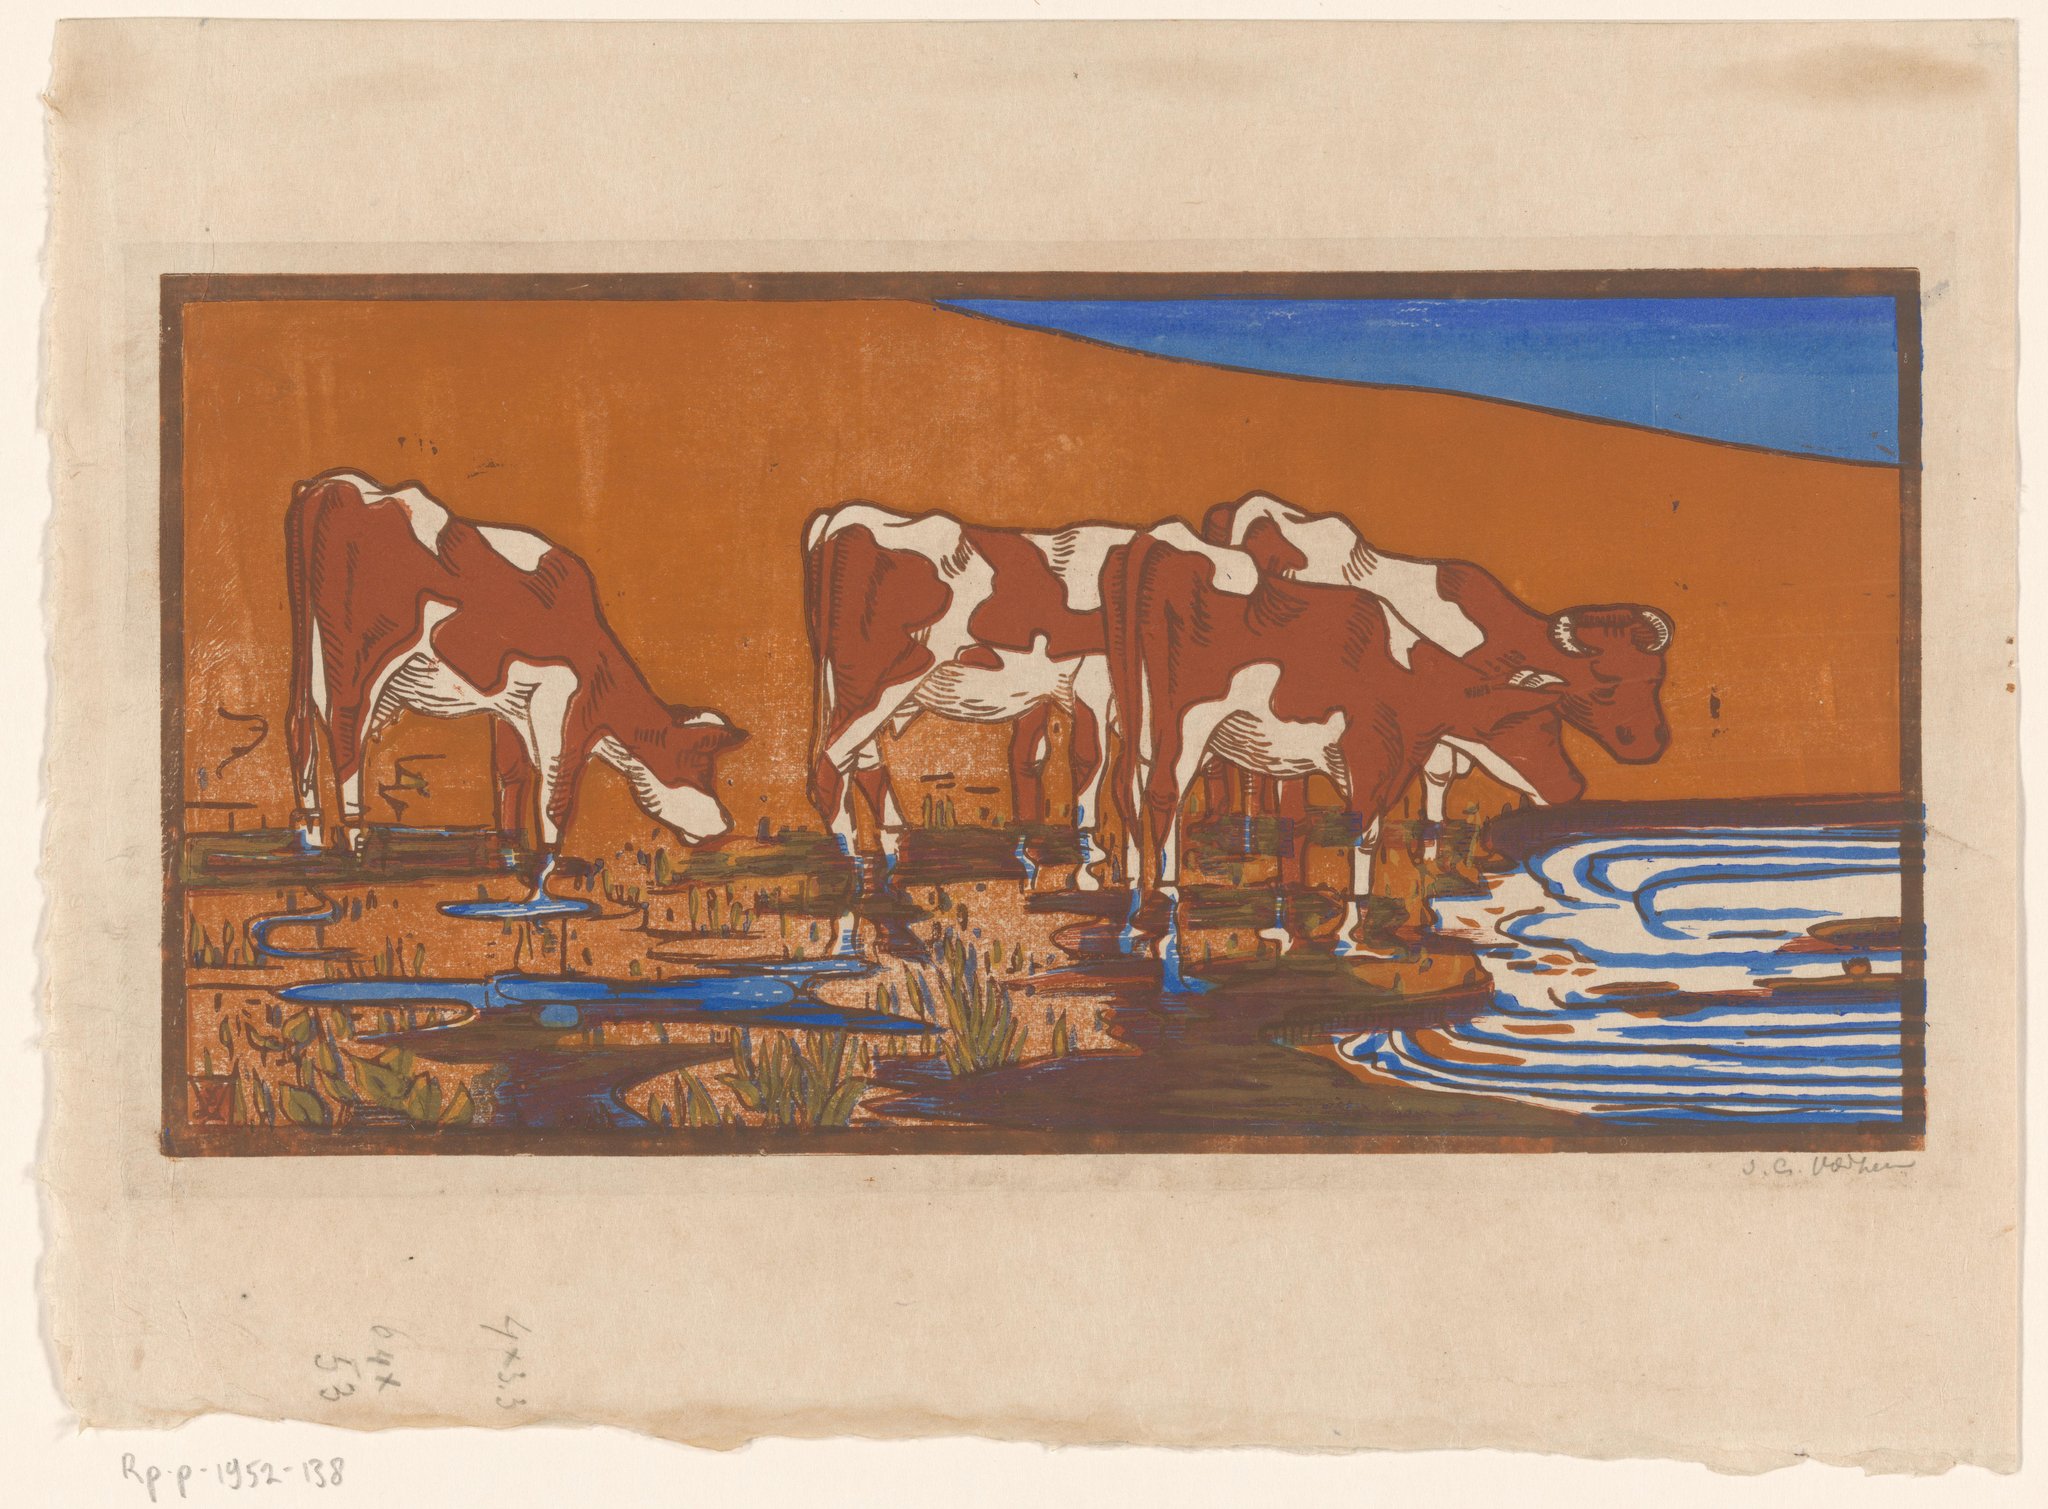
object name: print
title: Koeien aan het water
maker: jacobus gerardus veldheer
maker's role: draughtsman, print maker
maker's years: 1866-1954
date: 1876-1916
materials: paper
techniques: woodcut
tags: cow, pond, pool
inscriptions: collector's mark: Lugt 2228